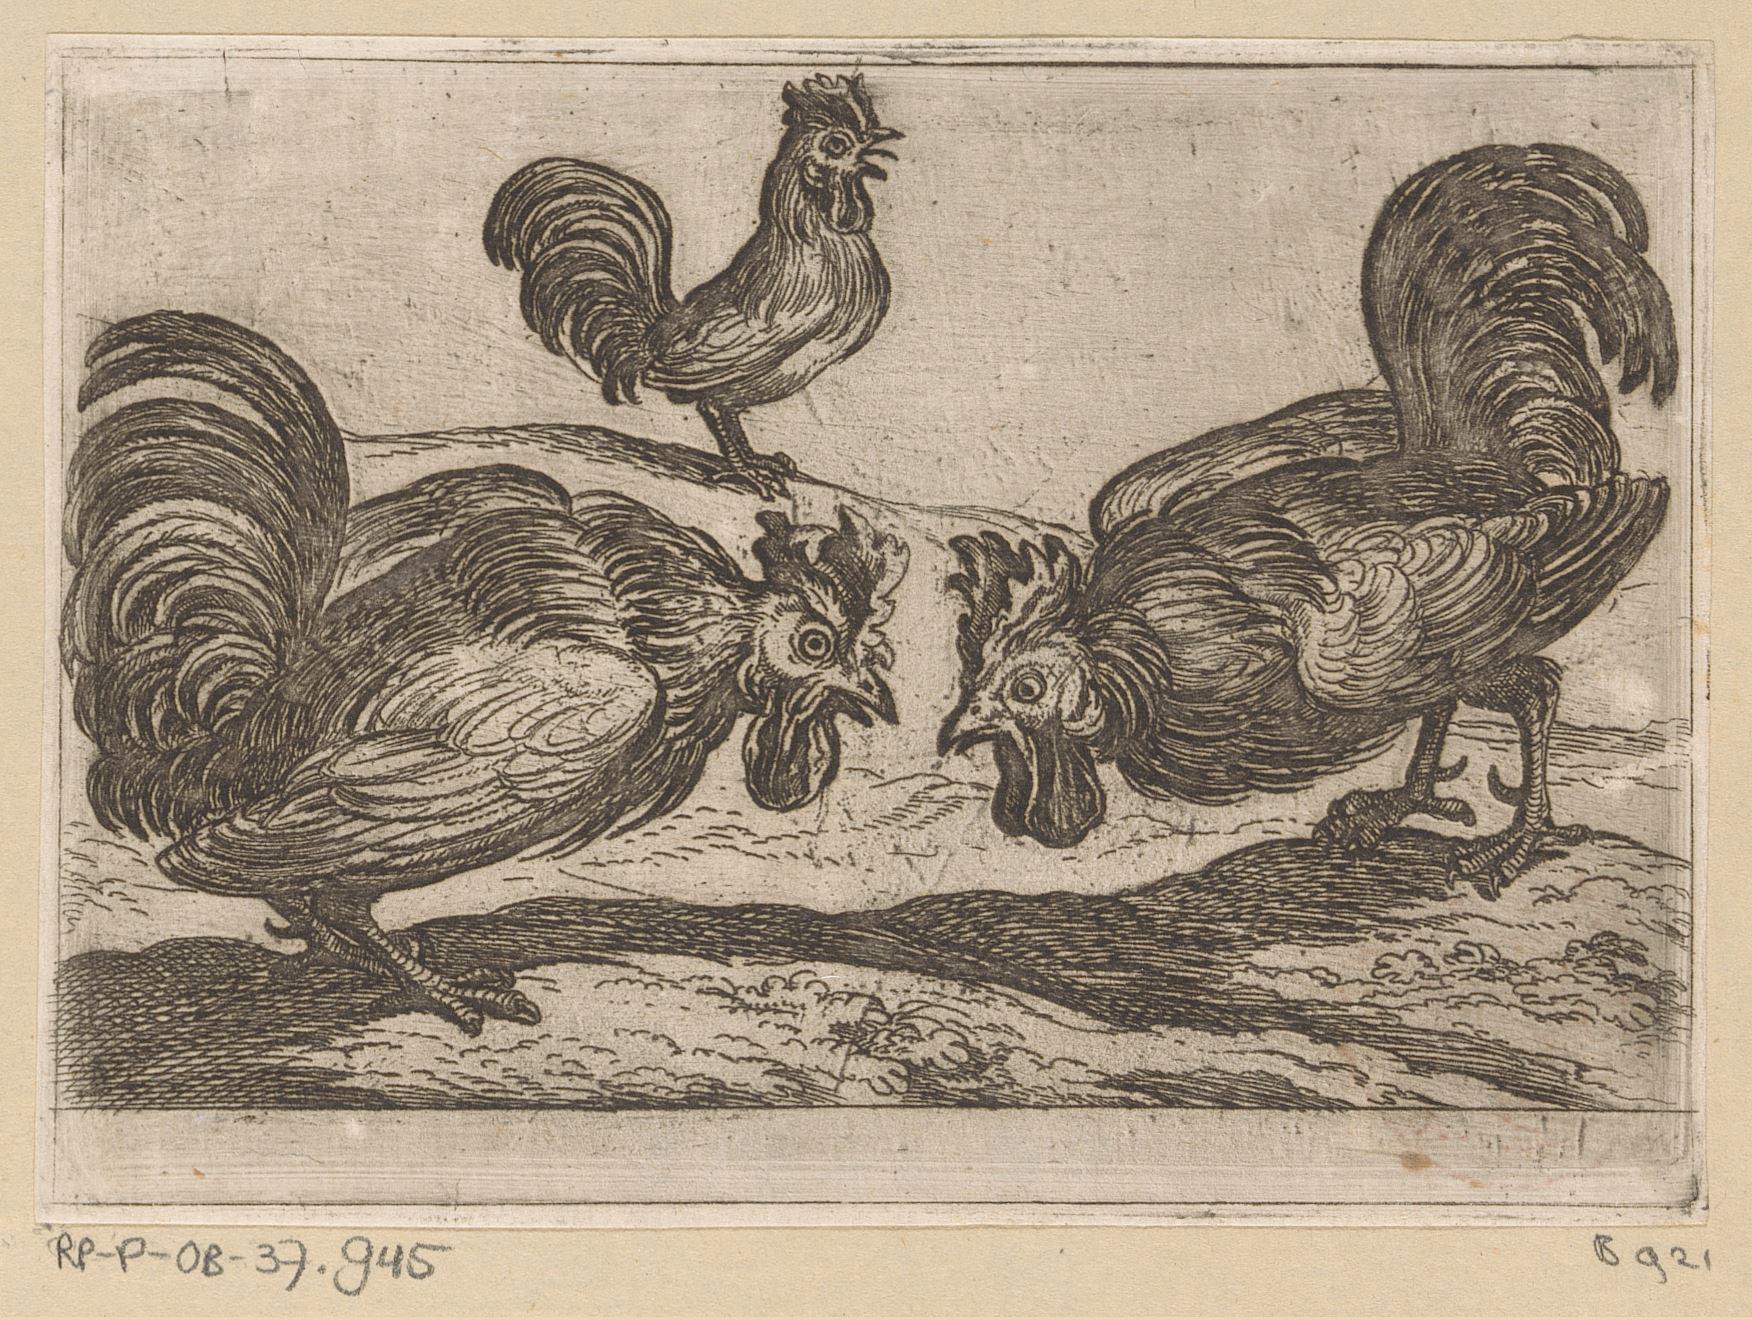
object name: print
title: Vechtende dieren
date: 1600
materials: paper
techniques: etching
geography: italy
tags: fowl (cock, hen, chicken, etc.), fowl (cock, hen, chicken, etc.) (+ male animal), cock-fighting, fighting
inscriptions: collector's mark: Lugt 240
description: Deze prent maakt deel uit van een reeks van 25 prenten (+ titelprent) van vechtende dieren.